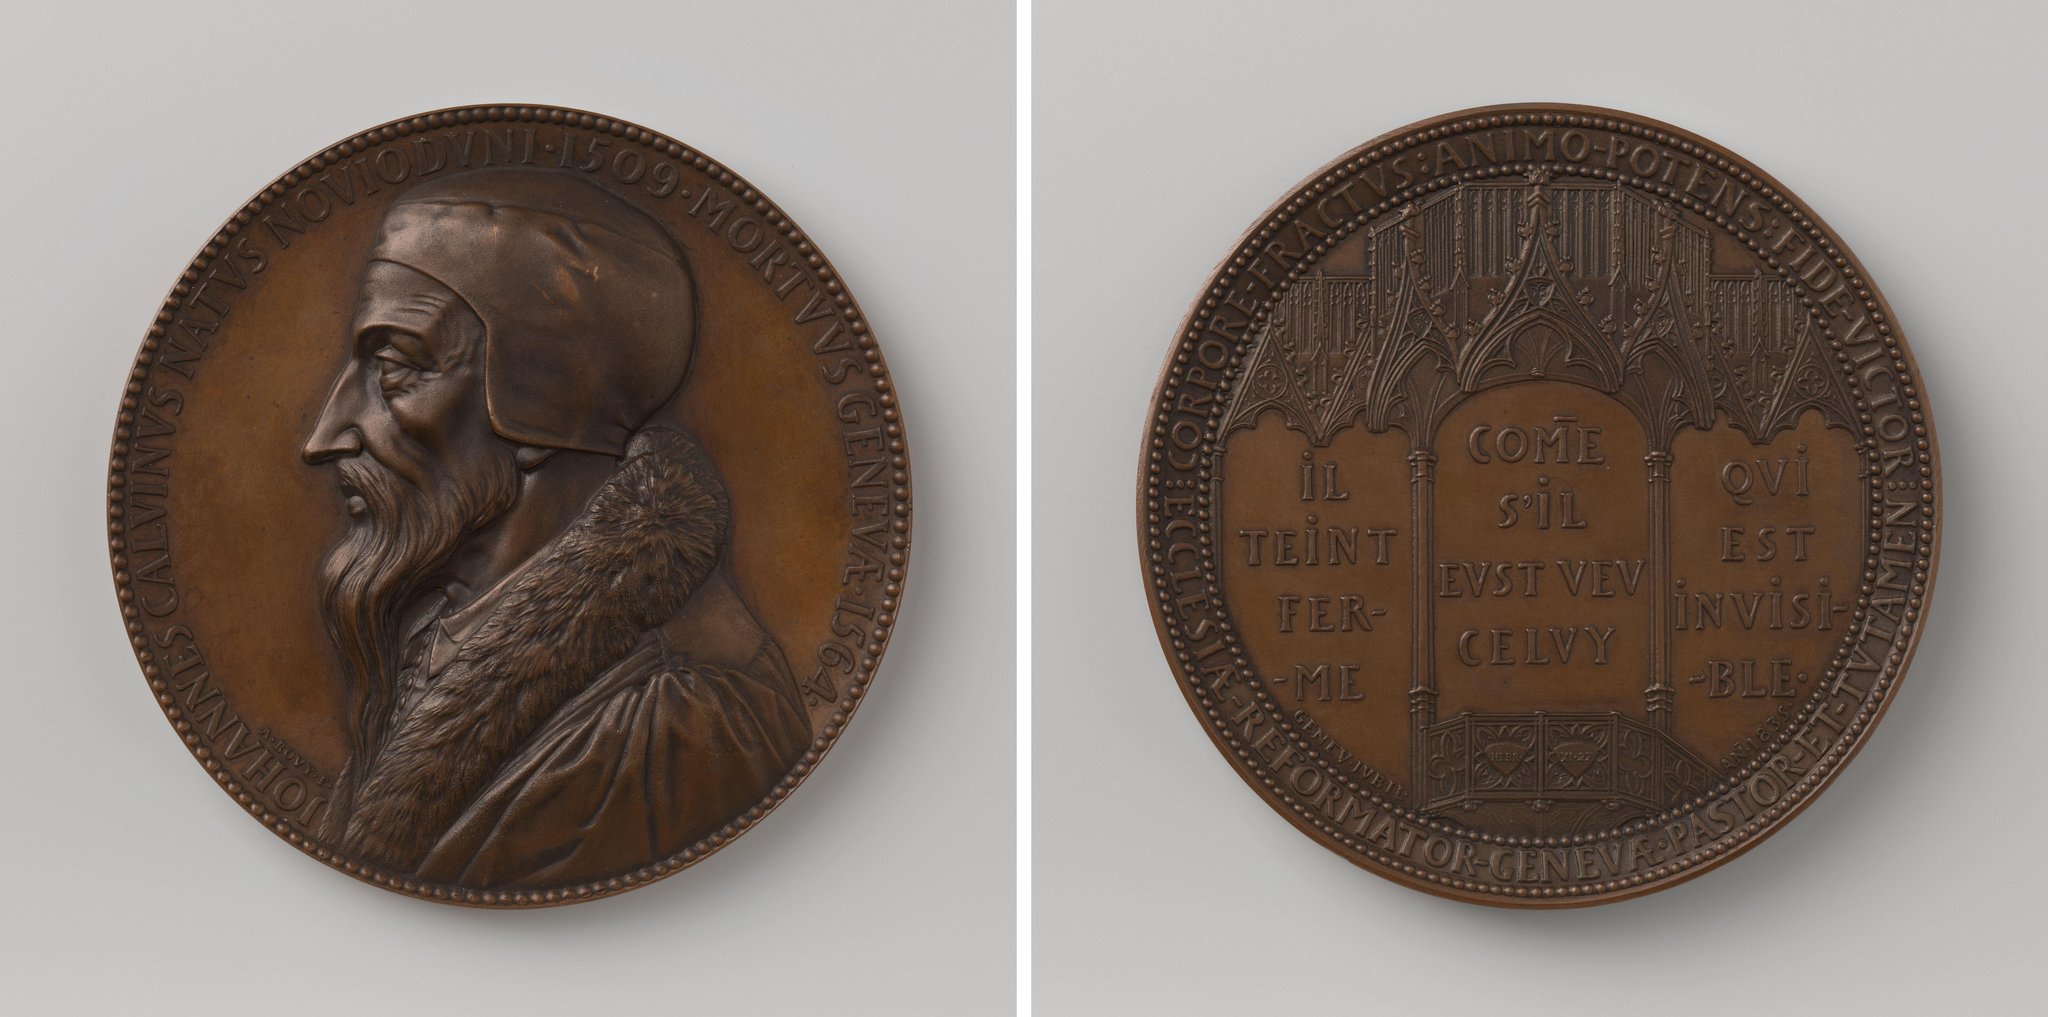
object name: history medal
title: Driehonderdjarige herdenking van de reformatie te Geneve, ter ere van Jean Calvijn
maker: jean françois antoine bovy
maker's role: medailleur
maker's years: 1795-1877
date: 1835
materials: bronze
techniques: striking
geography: paris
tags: noyon, theoloog, hervormer, johannes calvijn, genève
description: Bronzen penning. Voorzijde: borststuk man binnen omschrift. Keerzijde: opschrift, door twee zuilen die Gothische gevel dragen, in drieen verdeeld binnen omschrift.